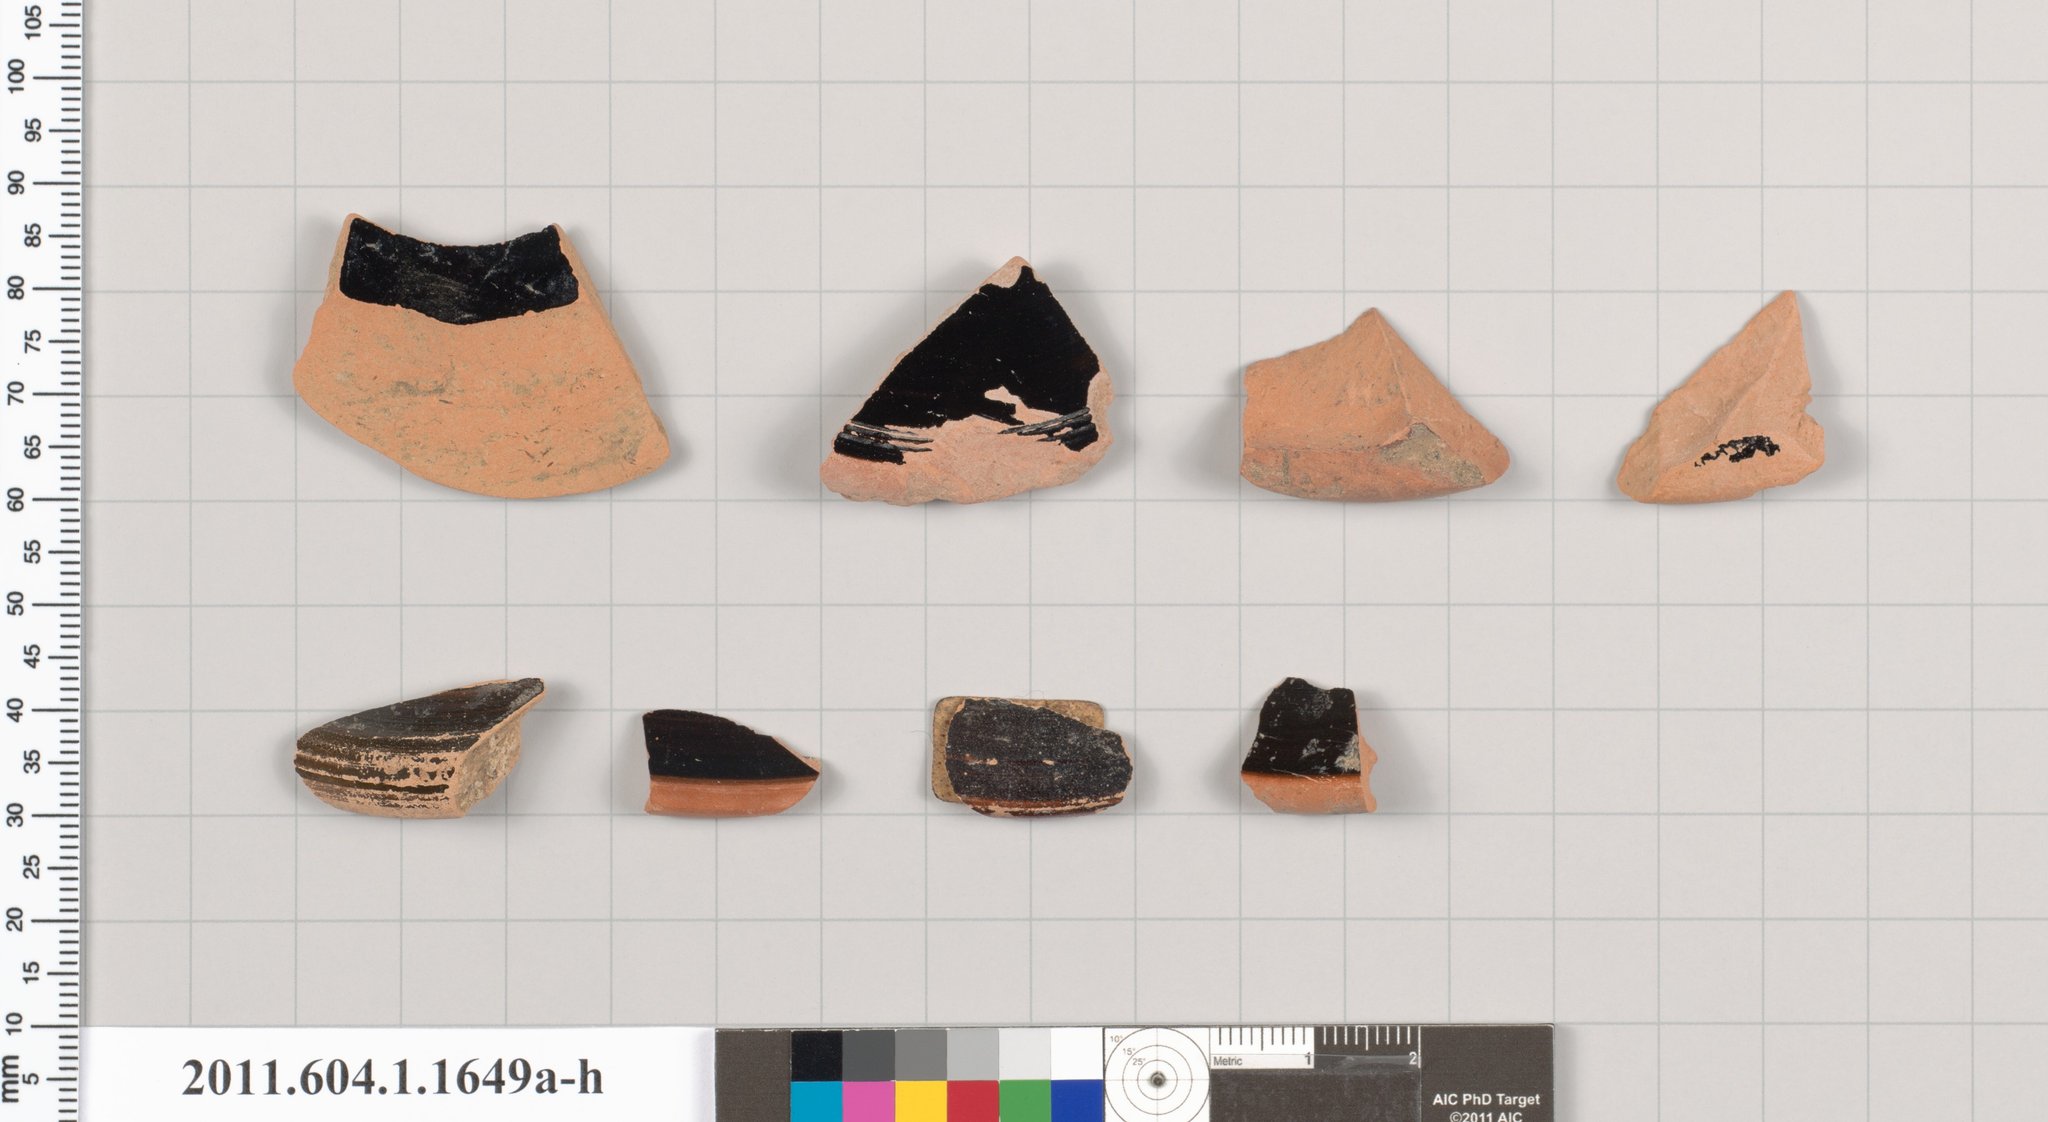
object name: kylix fragment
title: Terracotta fragments of kylikes (drinking cups)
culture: greek, attic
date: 500-401 BCE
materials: terracotta